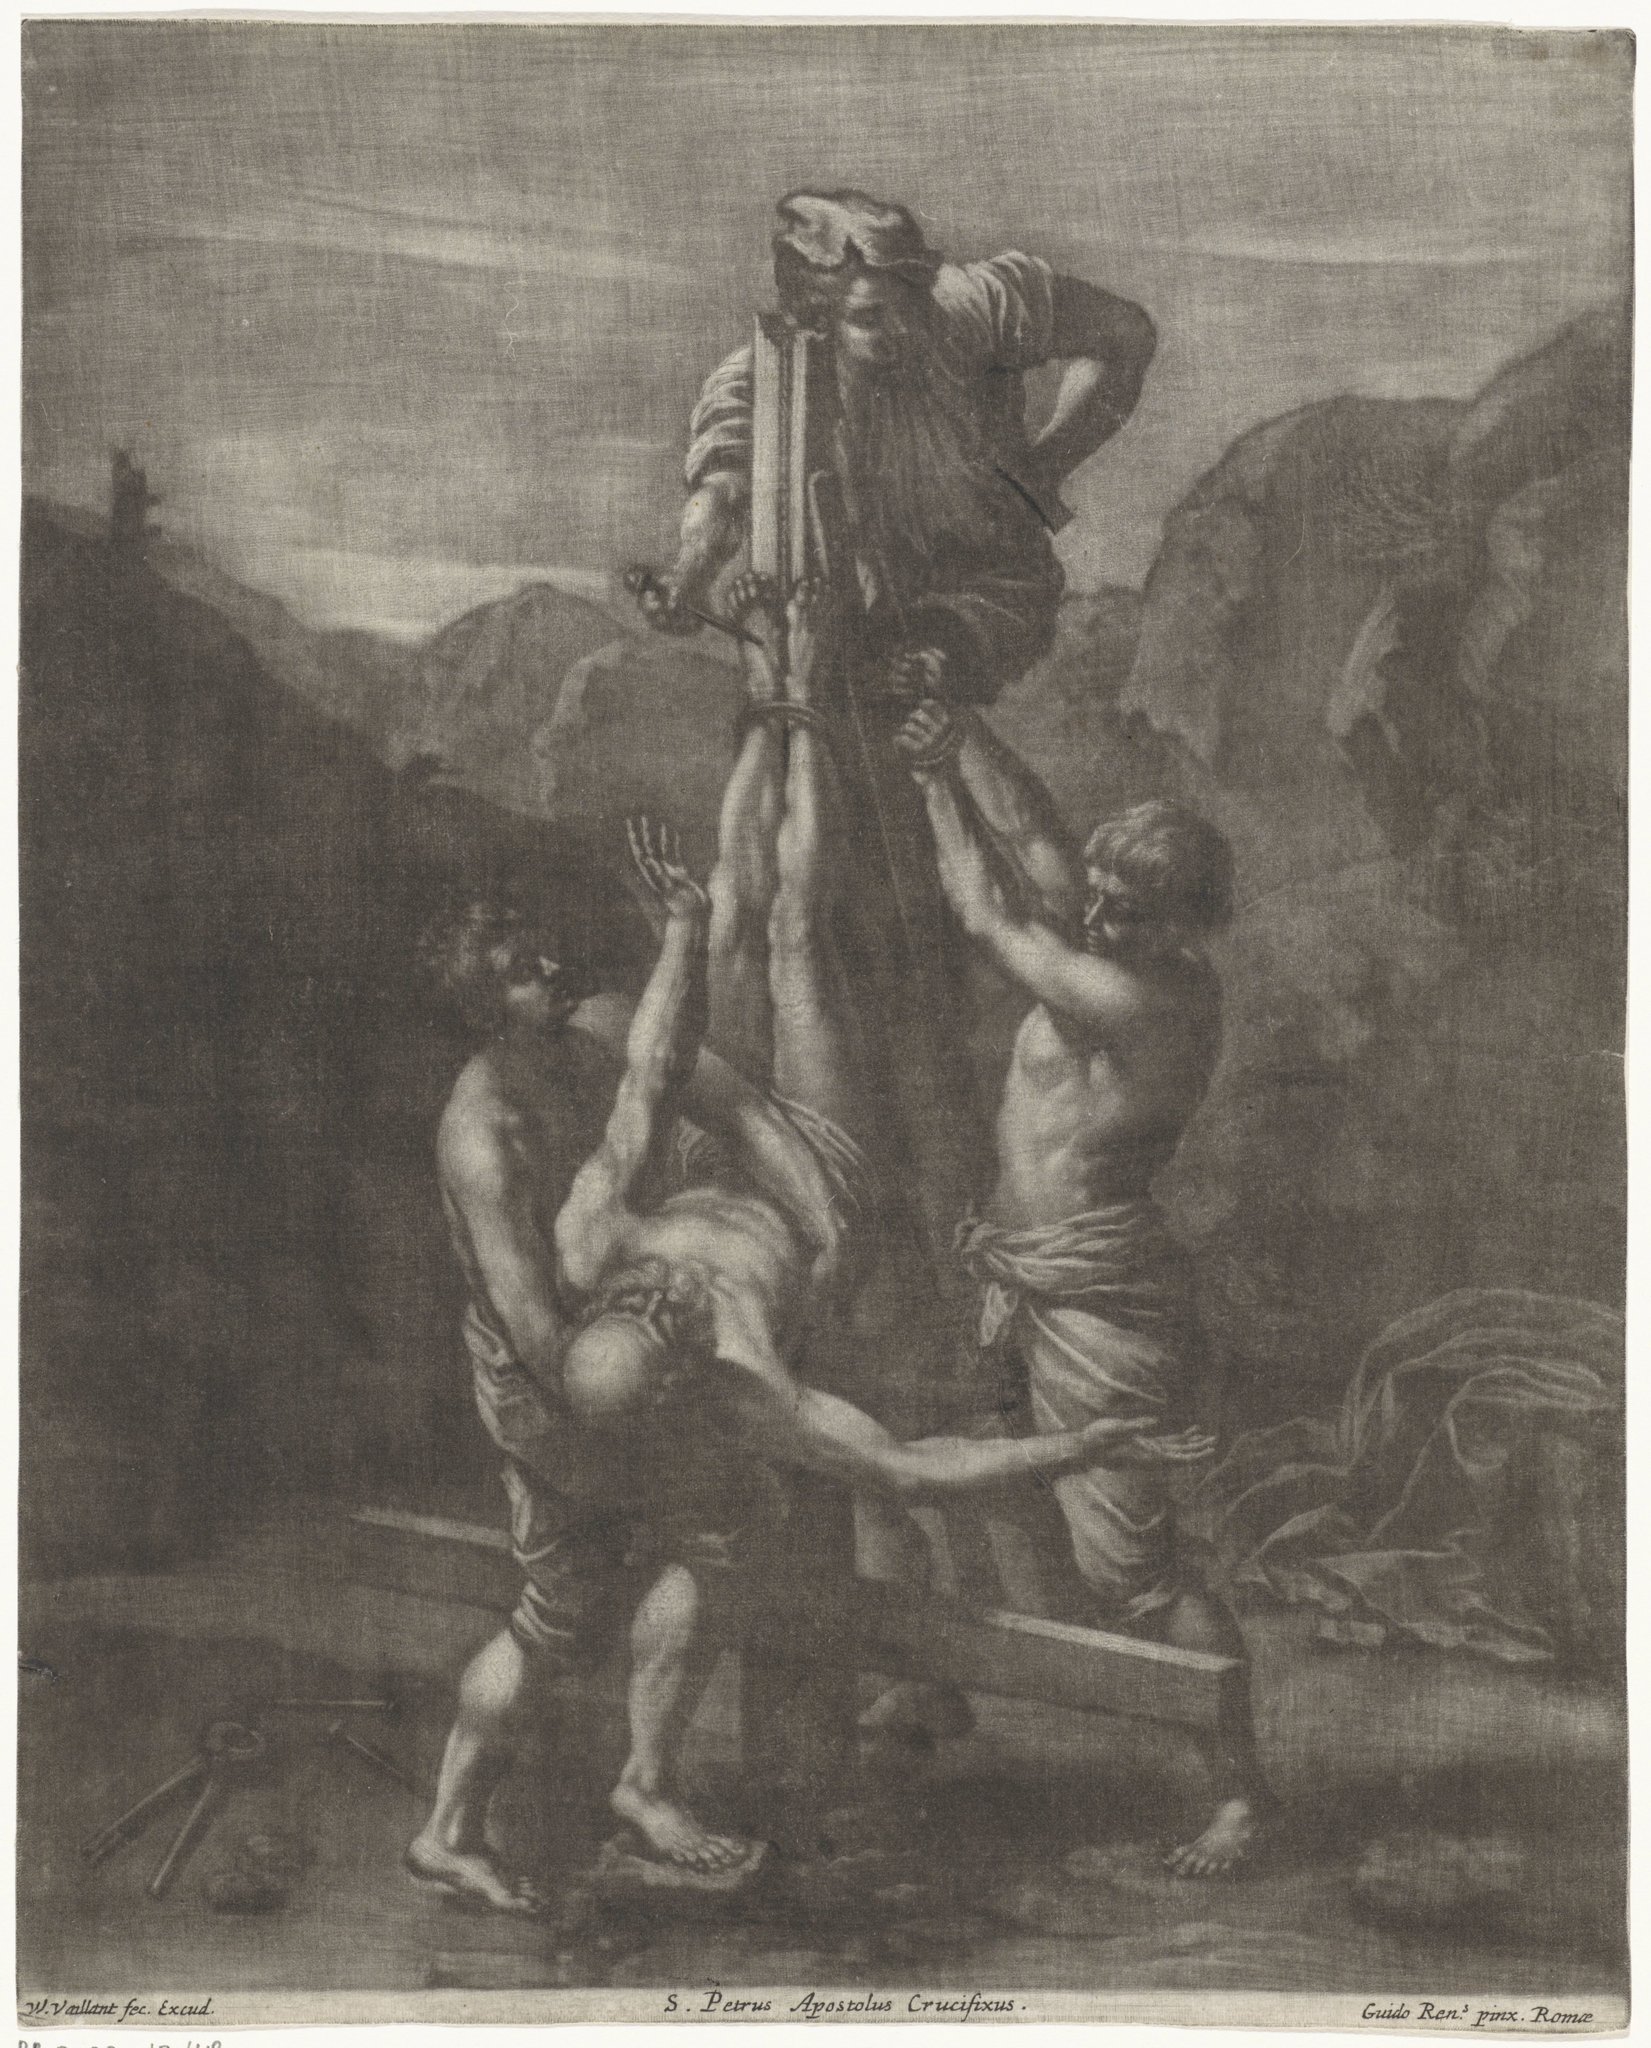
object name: print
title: Marteldood van Petrus aan het kruis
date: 1658-1677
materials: paper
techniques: mezzotint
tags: peter crucified upside down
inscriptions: collector's mark: Lugt 2228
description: Petrus wordt met zijn hoofd naar beneden gekruisigd.